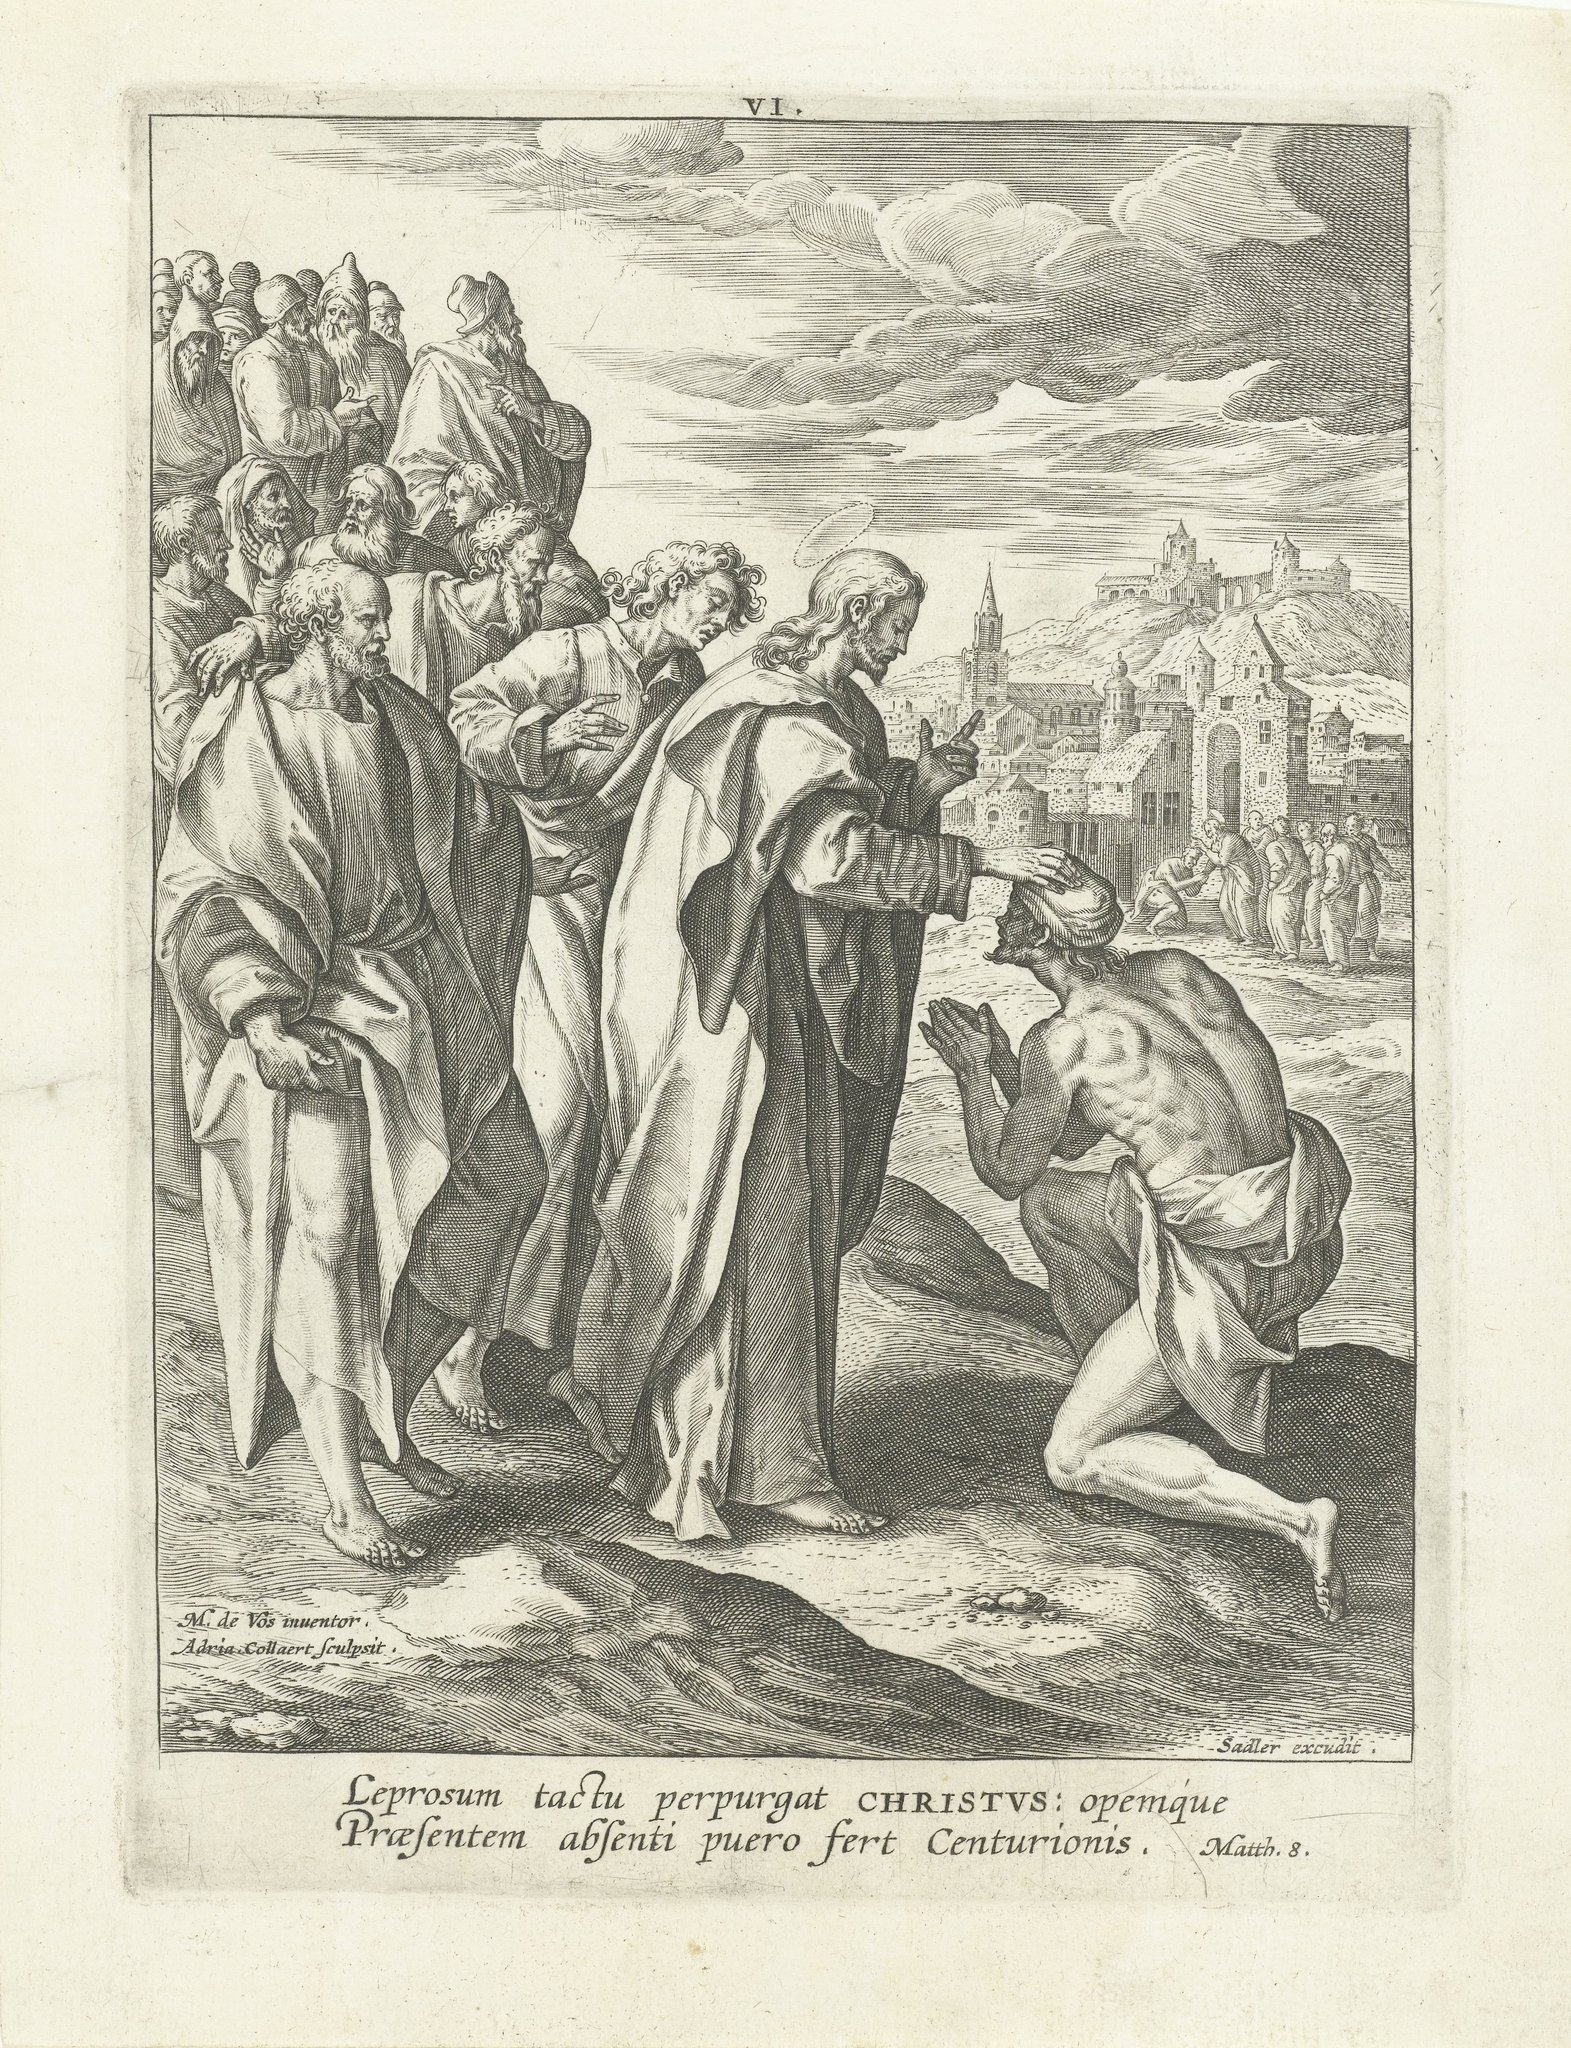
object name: print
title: Genezing van een melaatse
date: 1583-1588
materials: paper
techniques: engraving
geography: antwerp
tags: christ healing lepers, the servant (or son) of the centurion of capernaum is healed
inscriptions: collector's mark: Lugt 2228, collector's mark: Lugt 2760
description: Een lepralijder knielt voor Christus en bidt om genezing. Christus legt zijn hand op het hoofd van de man en geneest hem. Rondom Christus zijn apostelen (Matteüs 8:1-4). Op de achtergrond de genezing van de knecht van de hoofdman van Kafarnaüm (Matteüs 8:5-13). De prent heeft een Latijns onderschrift. De prent maakt deel uit van een serie over het leven van Christus.